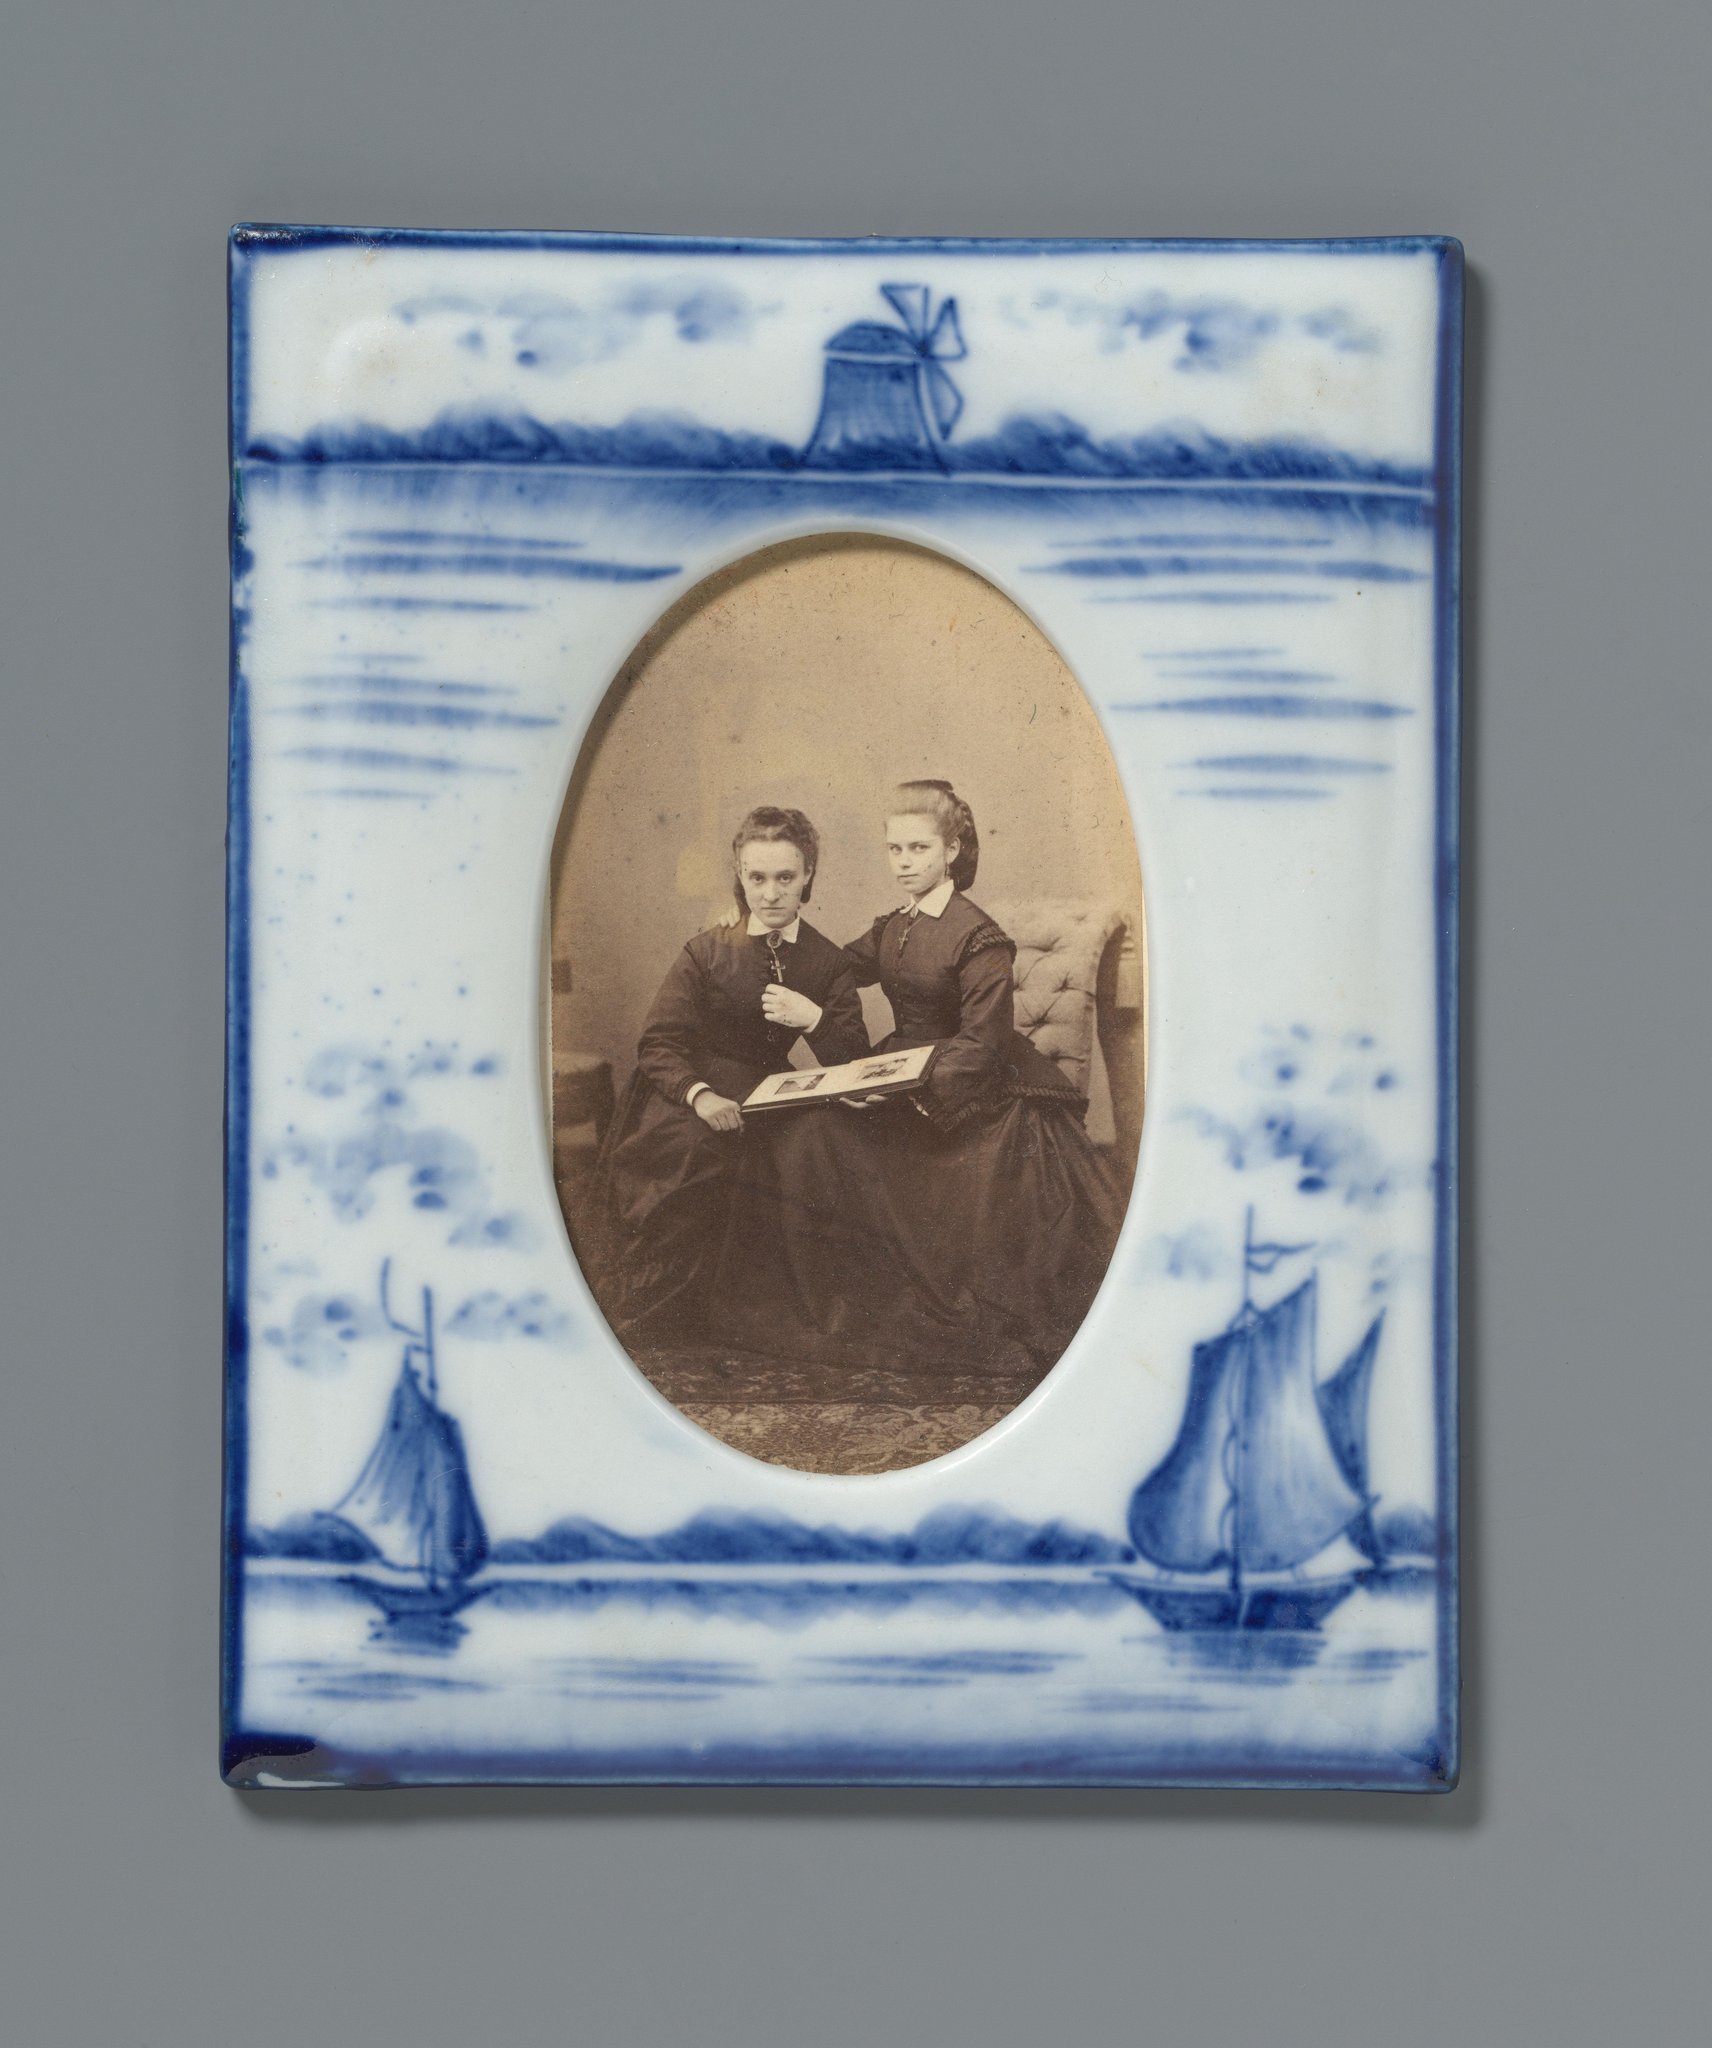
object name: frame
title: Portret van twee onbekende jonge vrouwen met fotoalbum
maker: eduard françois georges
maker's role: sculptor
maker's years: 1817-1895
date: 1863-1895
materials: cardboard, ceramic, paper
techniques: albumen print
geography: utrecht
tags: adolescent, young woman, maiden, anonymous historical person portrayed, book in which illustrations are essential - mm - book open, utrecht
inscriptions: inscription: ‘Georges./ Statuaire/ Photographe/ Utrecht/ Vrouw Jutte straat/ 344.’, number: ‘6267’